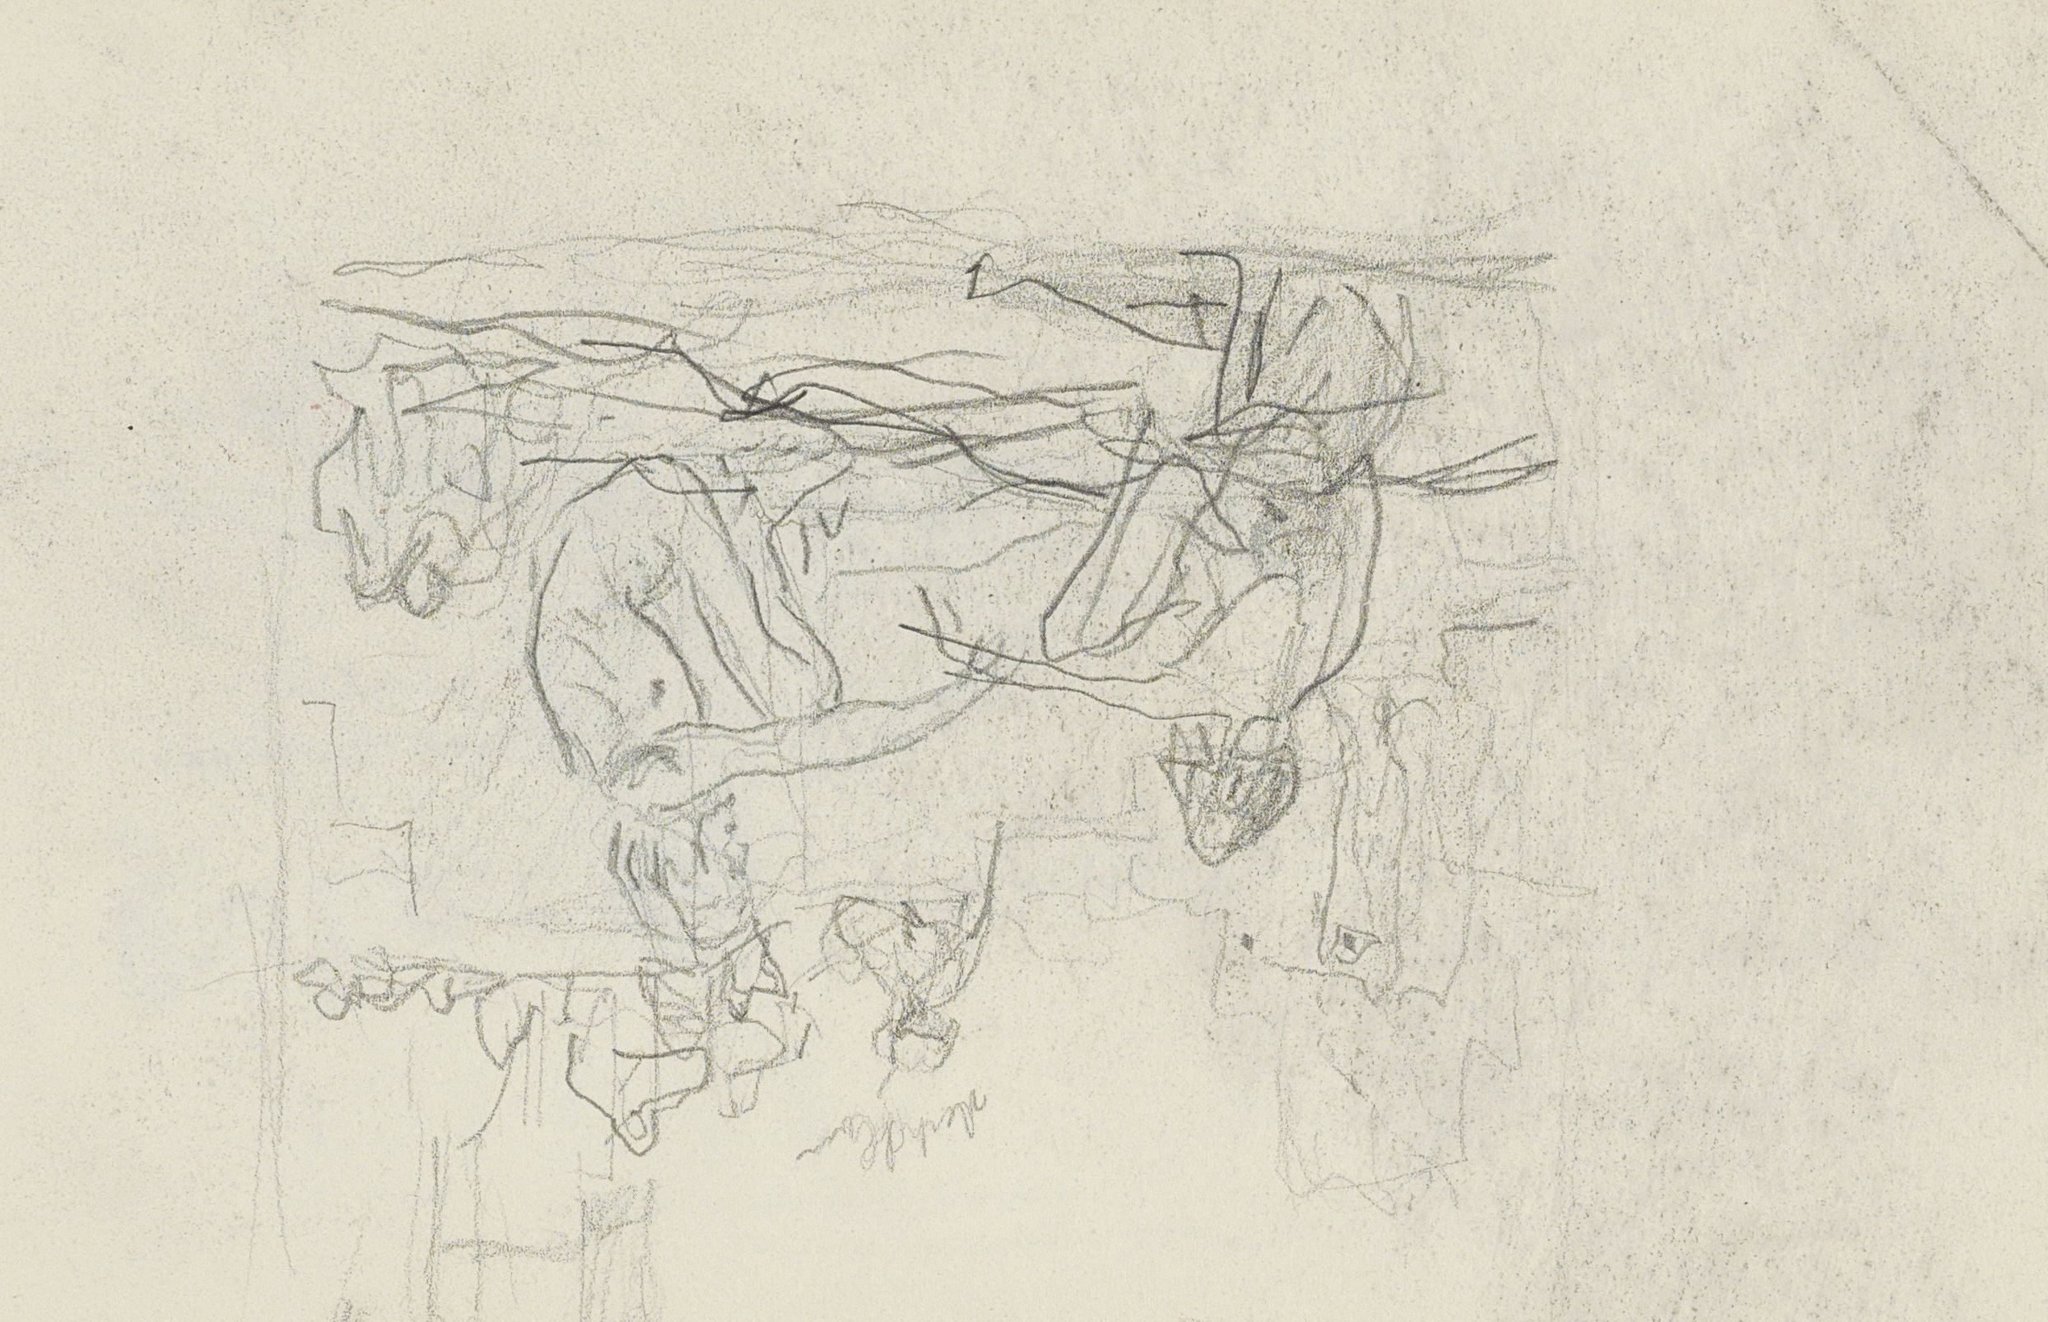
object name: sketchbook leaf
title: Indiërs zittend bij een trap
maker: marius bauer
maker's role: draughtsman, print maker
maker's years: 1867-1932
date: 1924-1925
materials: paper, pencil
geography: india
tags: sitting figure, flight of steps, asiatic races and peoples: indians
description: Pagina 57 uit een schetsboek met 48 bladen.